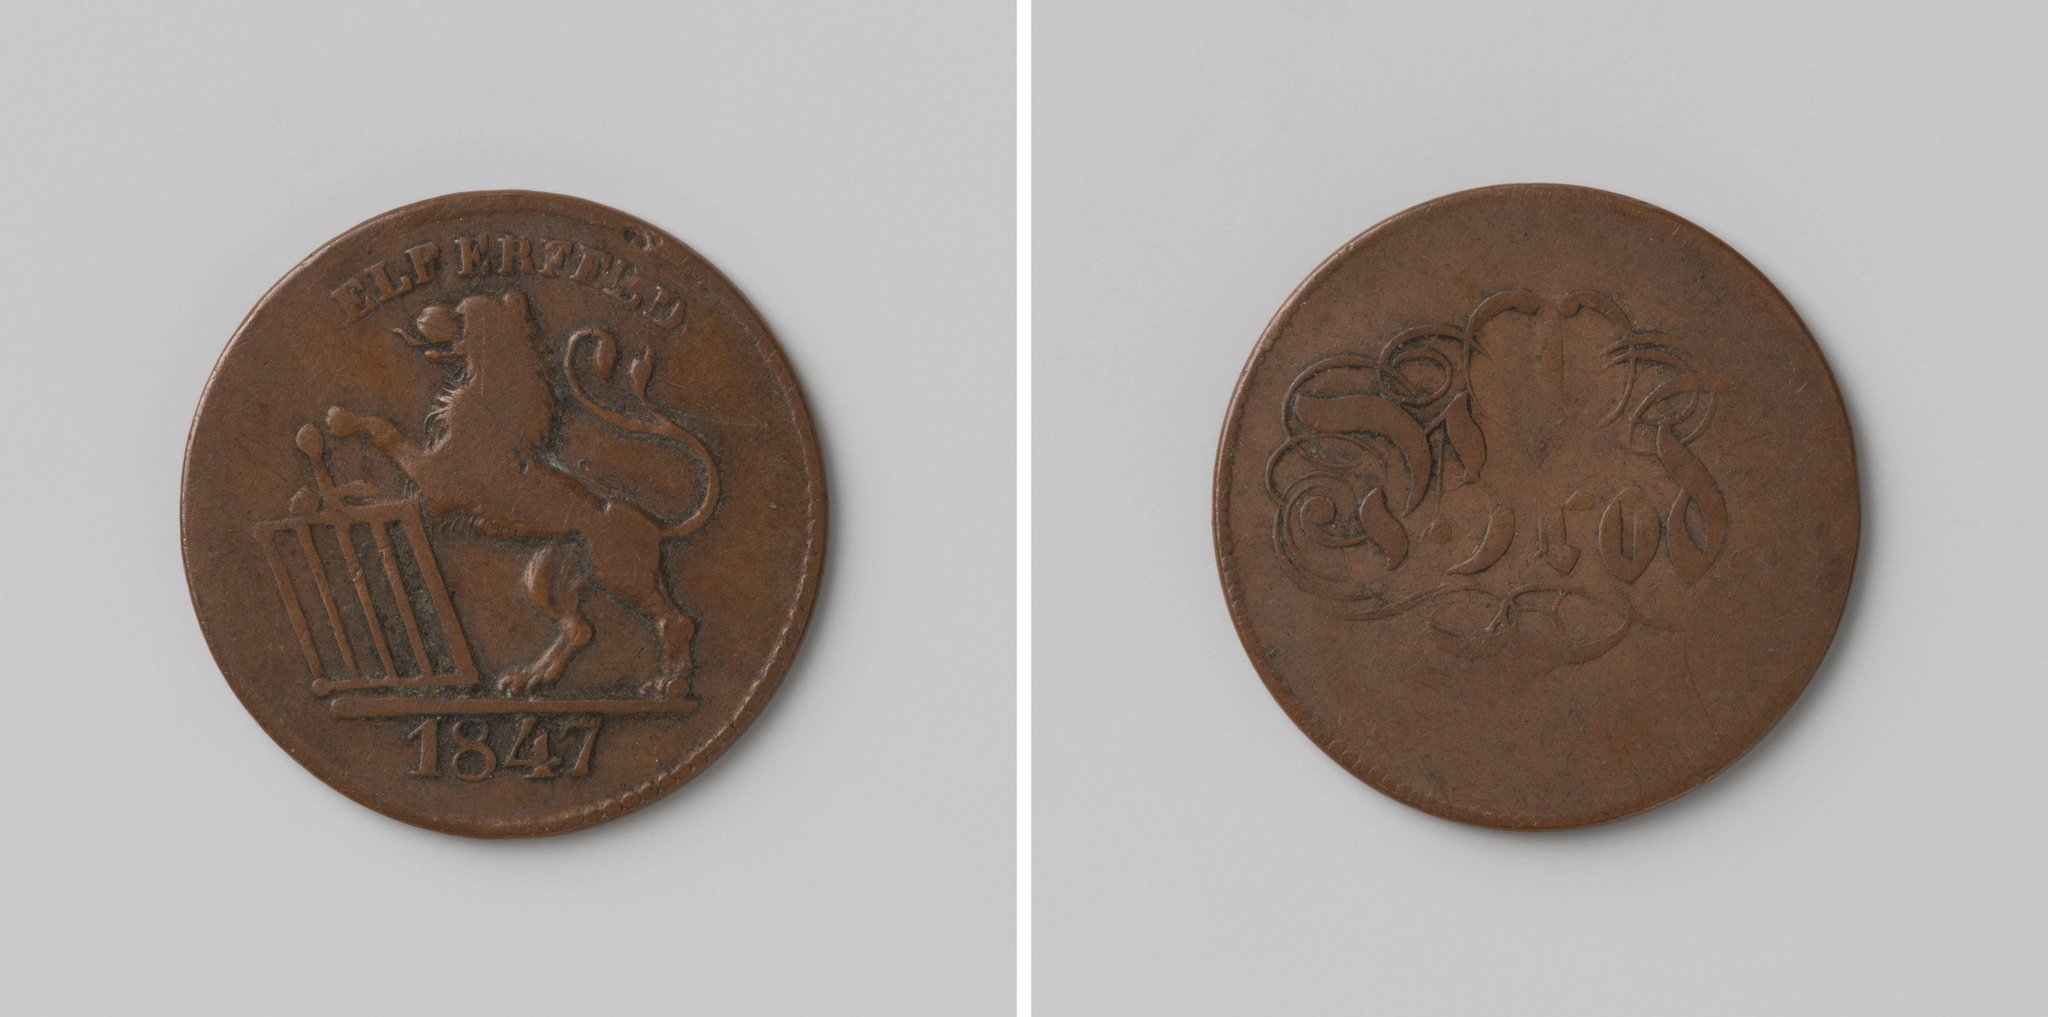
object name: bread token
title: Elberfelder Kornverein, loodje goed voor een brood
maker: Anonymous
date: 1847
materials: copper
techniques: striking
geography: elberfeld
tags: elberfeld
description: Koperen penning. Voorzijde: leeuw met voorpoten staande op altaar onder opschrift; afsnede: jaartal. Keerzijde: opschrift